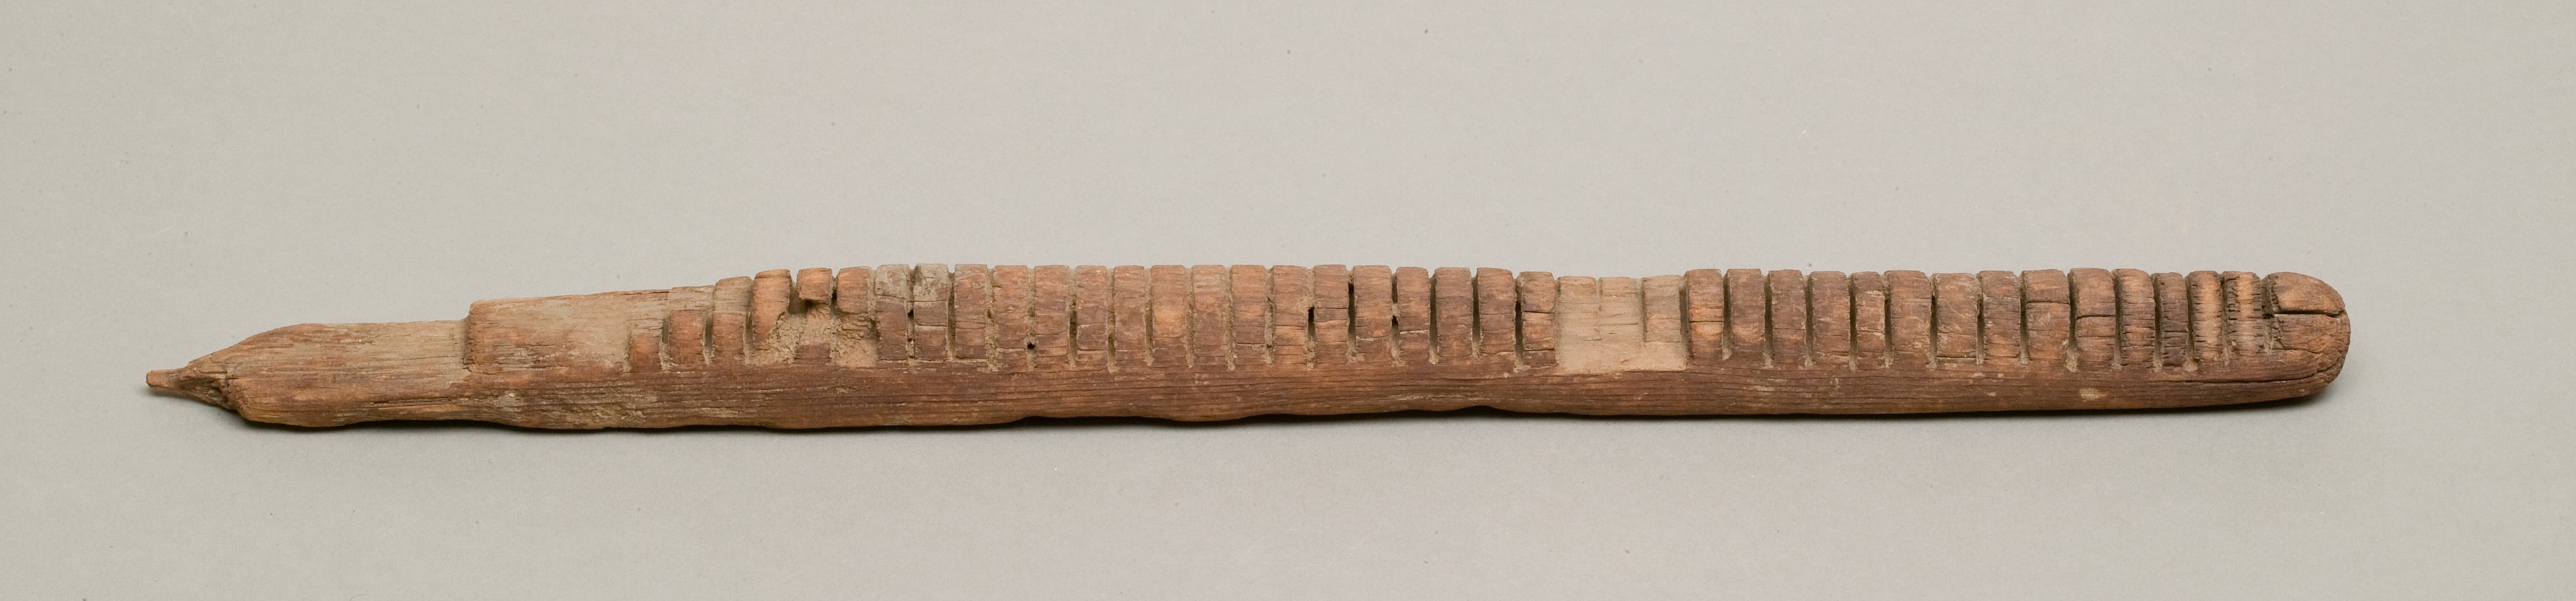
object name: warp spacer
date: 1295-1070 BCE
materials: wood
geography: egypt